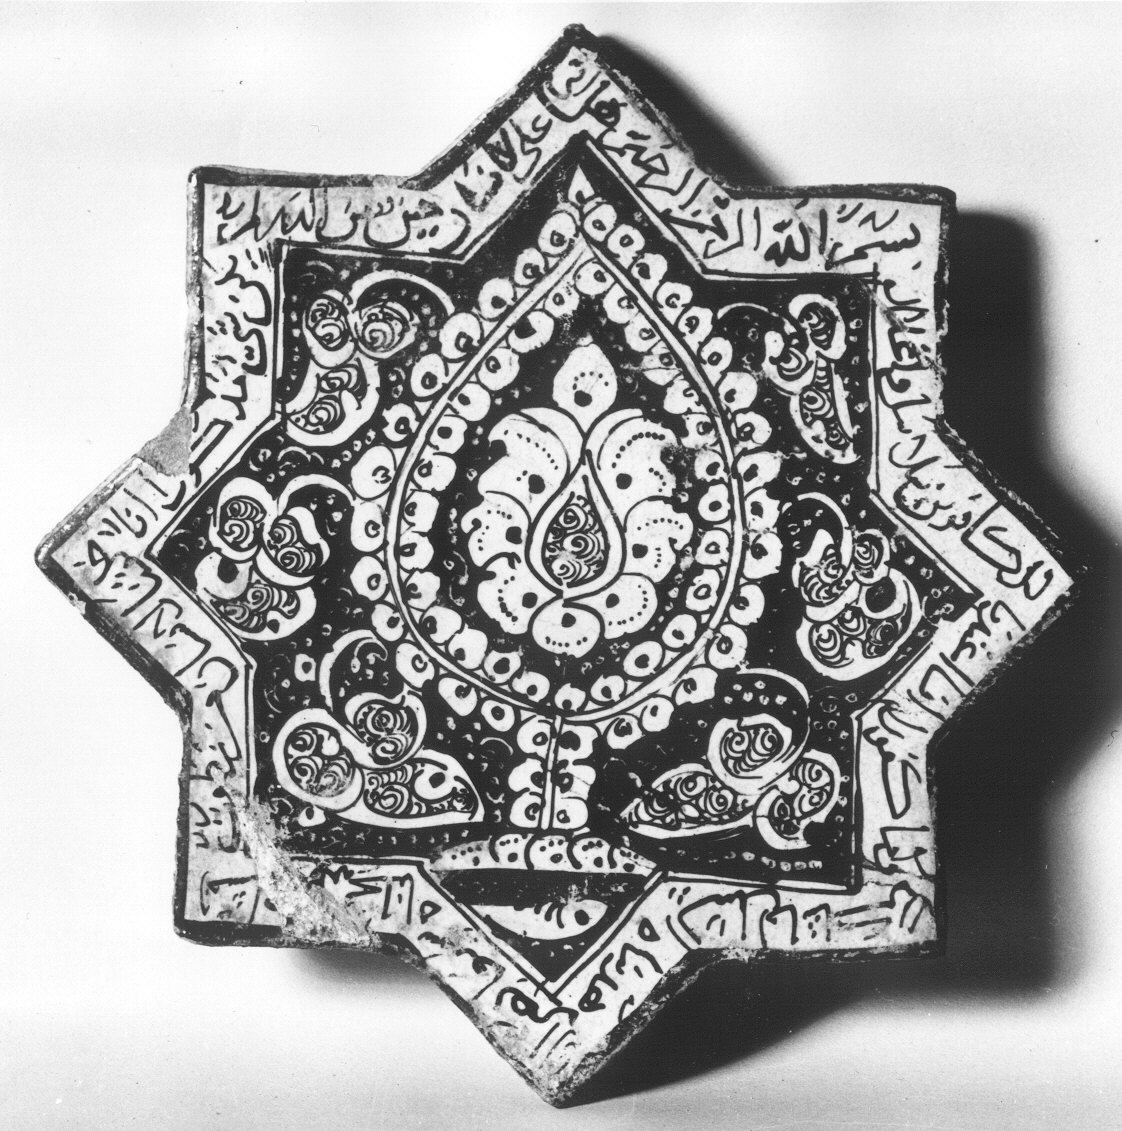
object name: tile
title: Star-Shaped Tile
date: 1201-1300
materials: cobalt, glaze, stonepaste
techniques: luster painting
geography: iran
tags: leaves